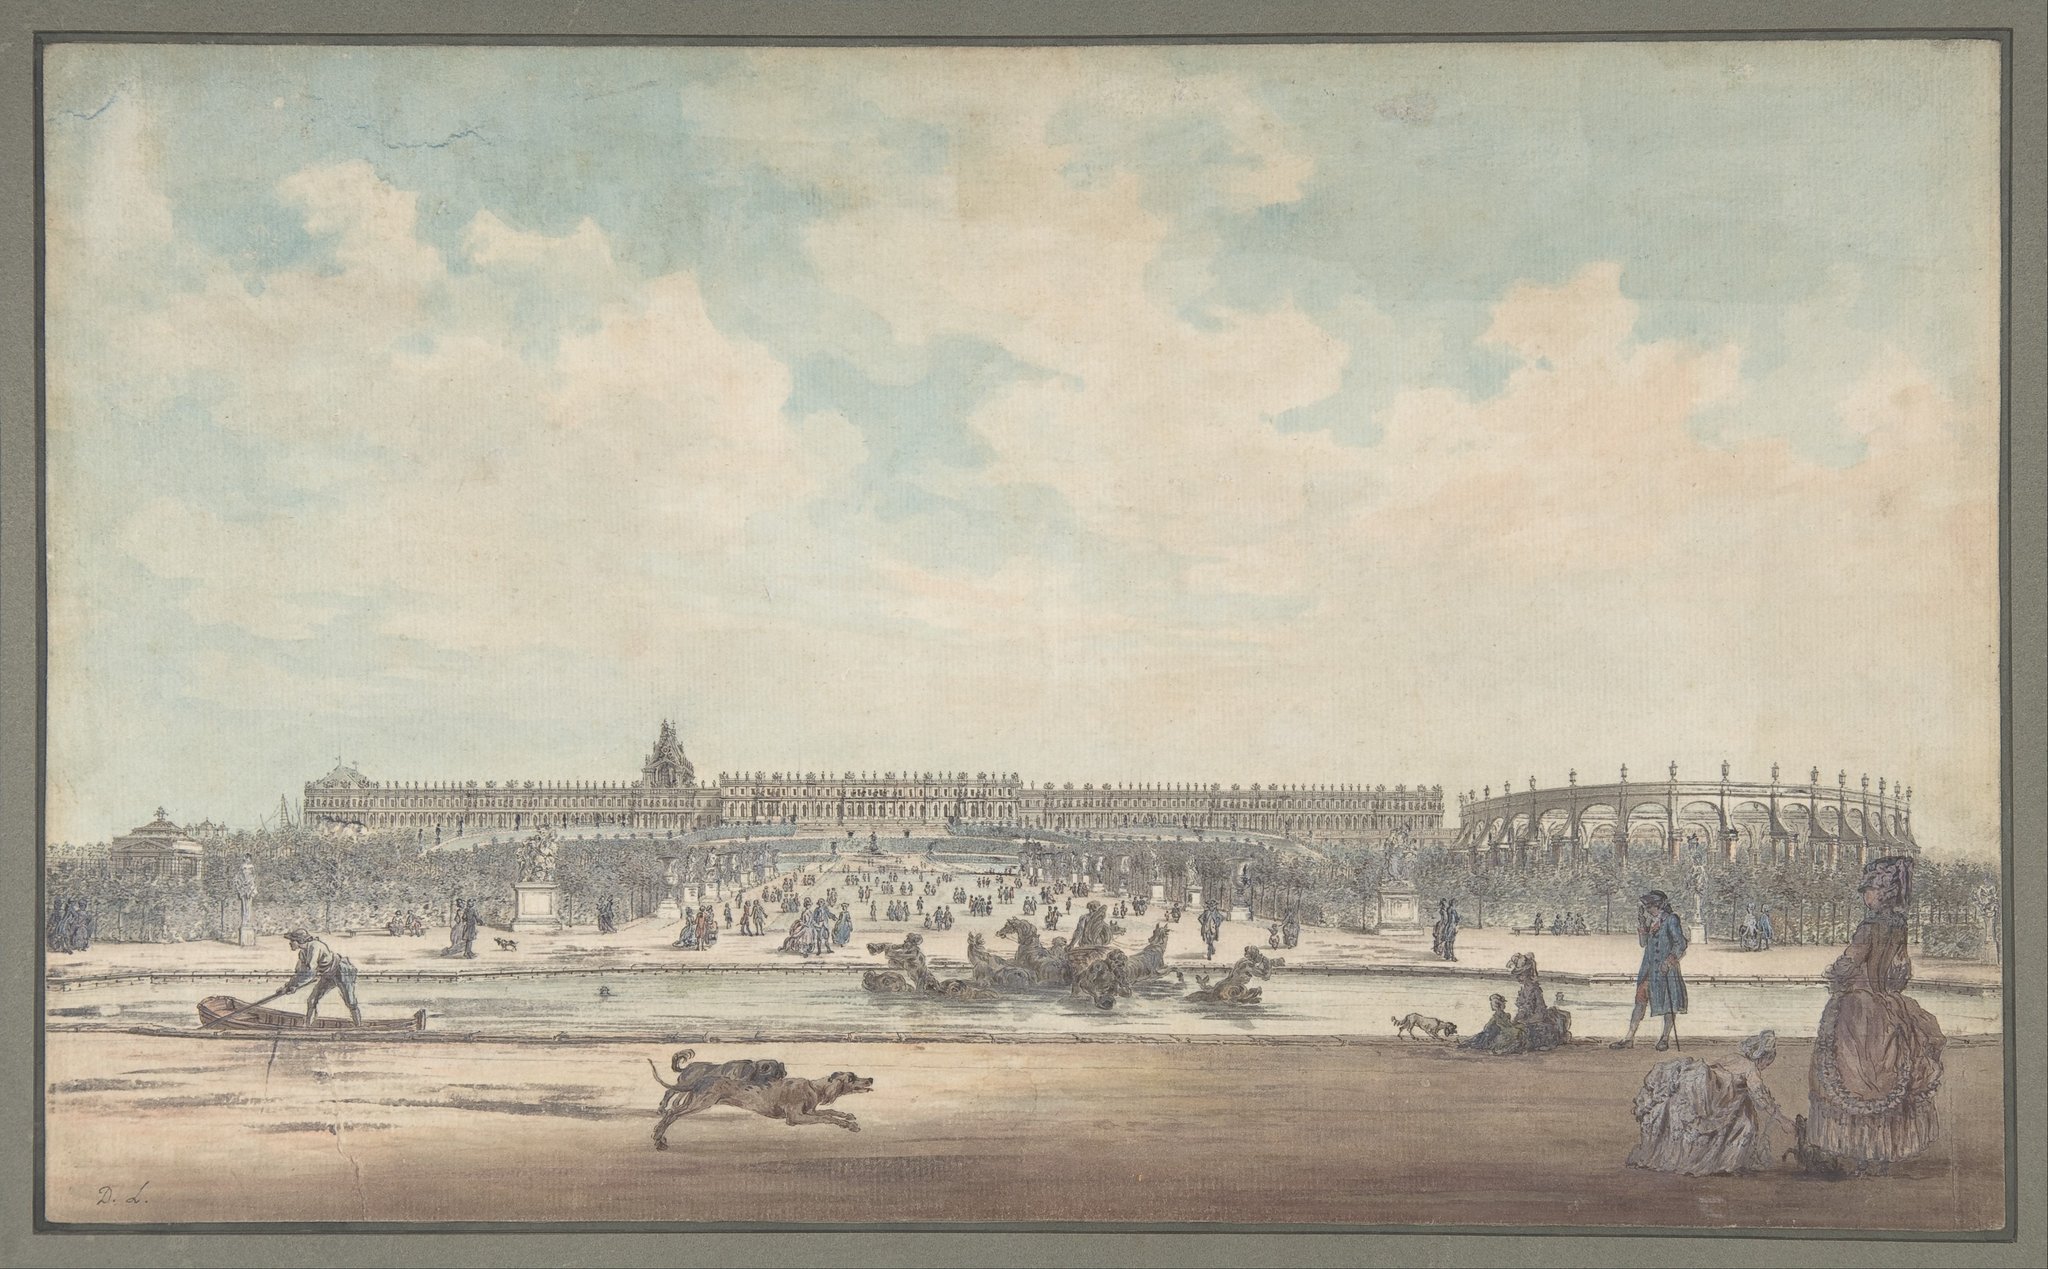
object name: drawing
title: The Château de Versailles Seen from the Gardens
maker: louis nicolas de lespinasse, called the chevalier de lespinasse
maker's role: artist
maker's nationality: french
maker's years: 1734-1808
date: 1779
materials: graphite, ink, watercolor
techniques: heightening, pen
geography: france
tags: palaces,gardens,dogs,crowd,boats